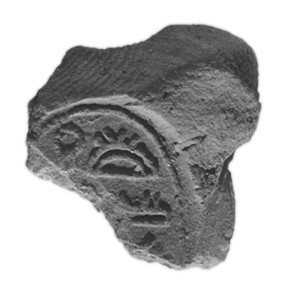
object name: sealing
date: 2030-1640 BCE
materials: clay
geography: egypt